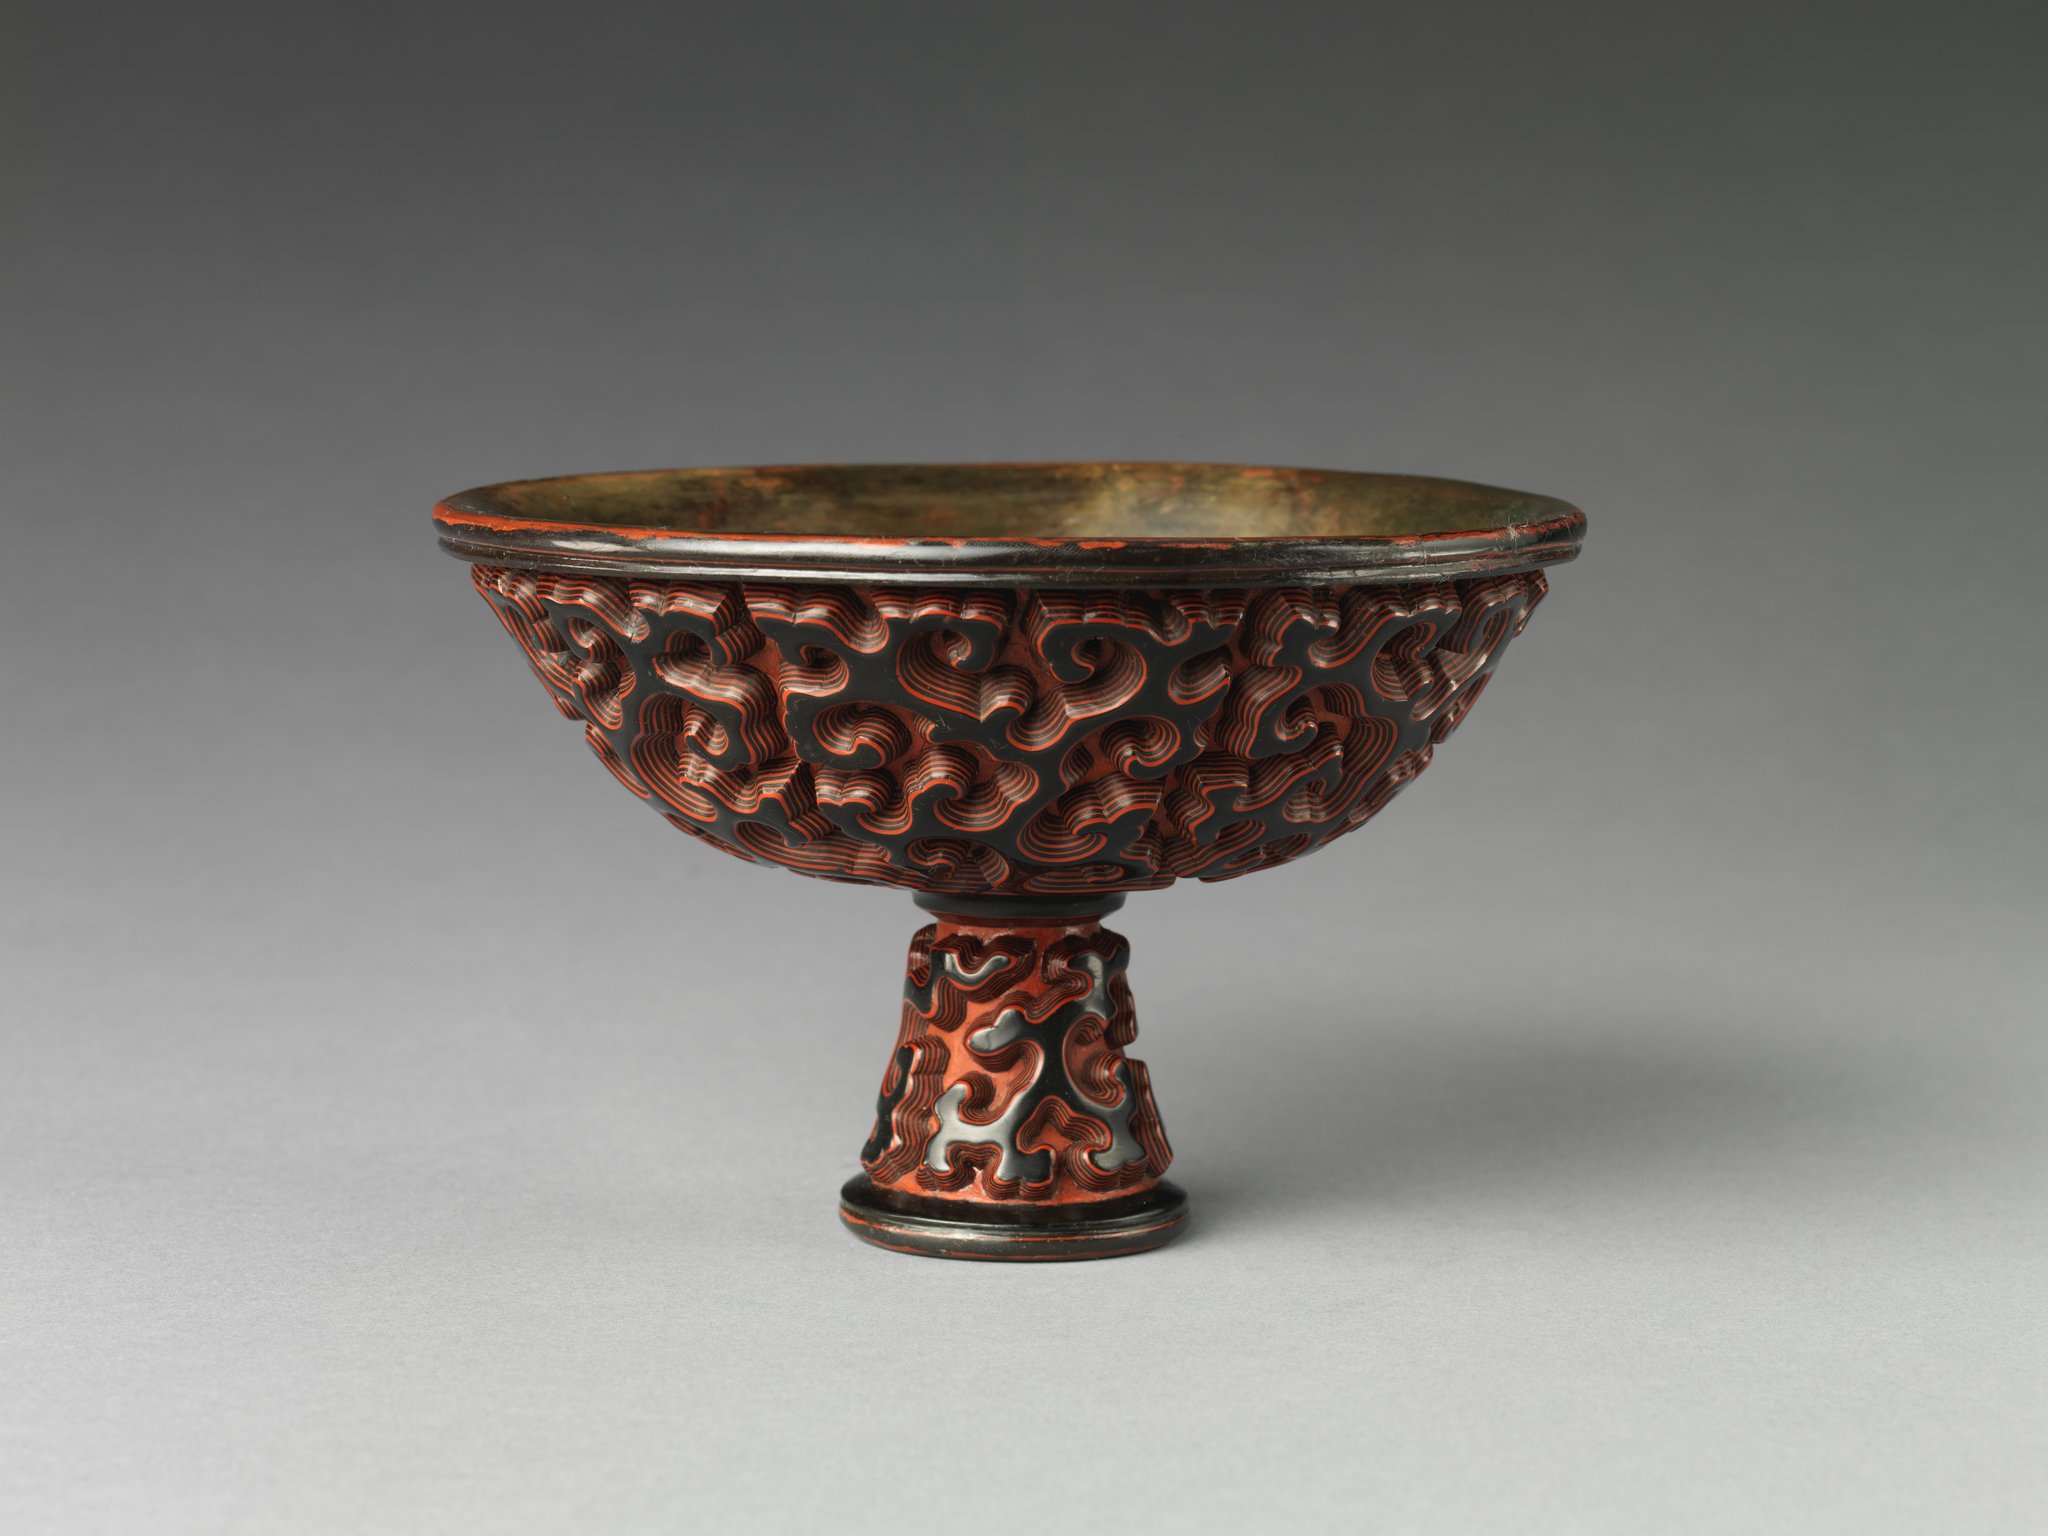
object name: stem cup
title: Stem cup with stylized clouds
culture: chinese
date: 1301-1400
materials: lacquer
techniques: carving